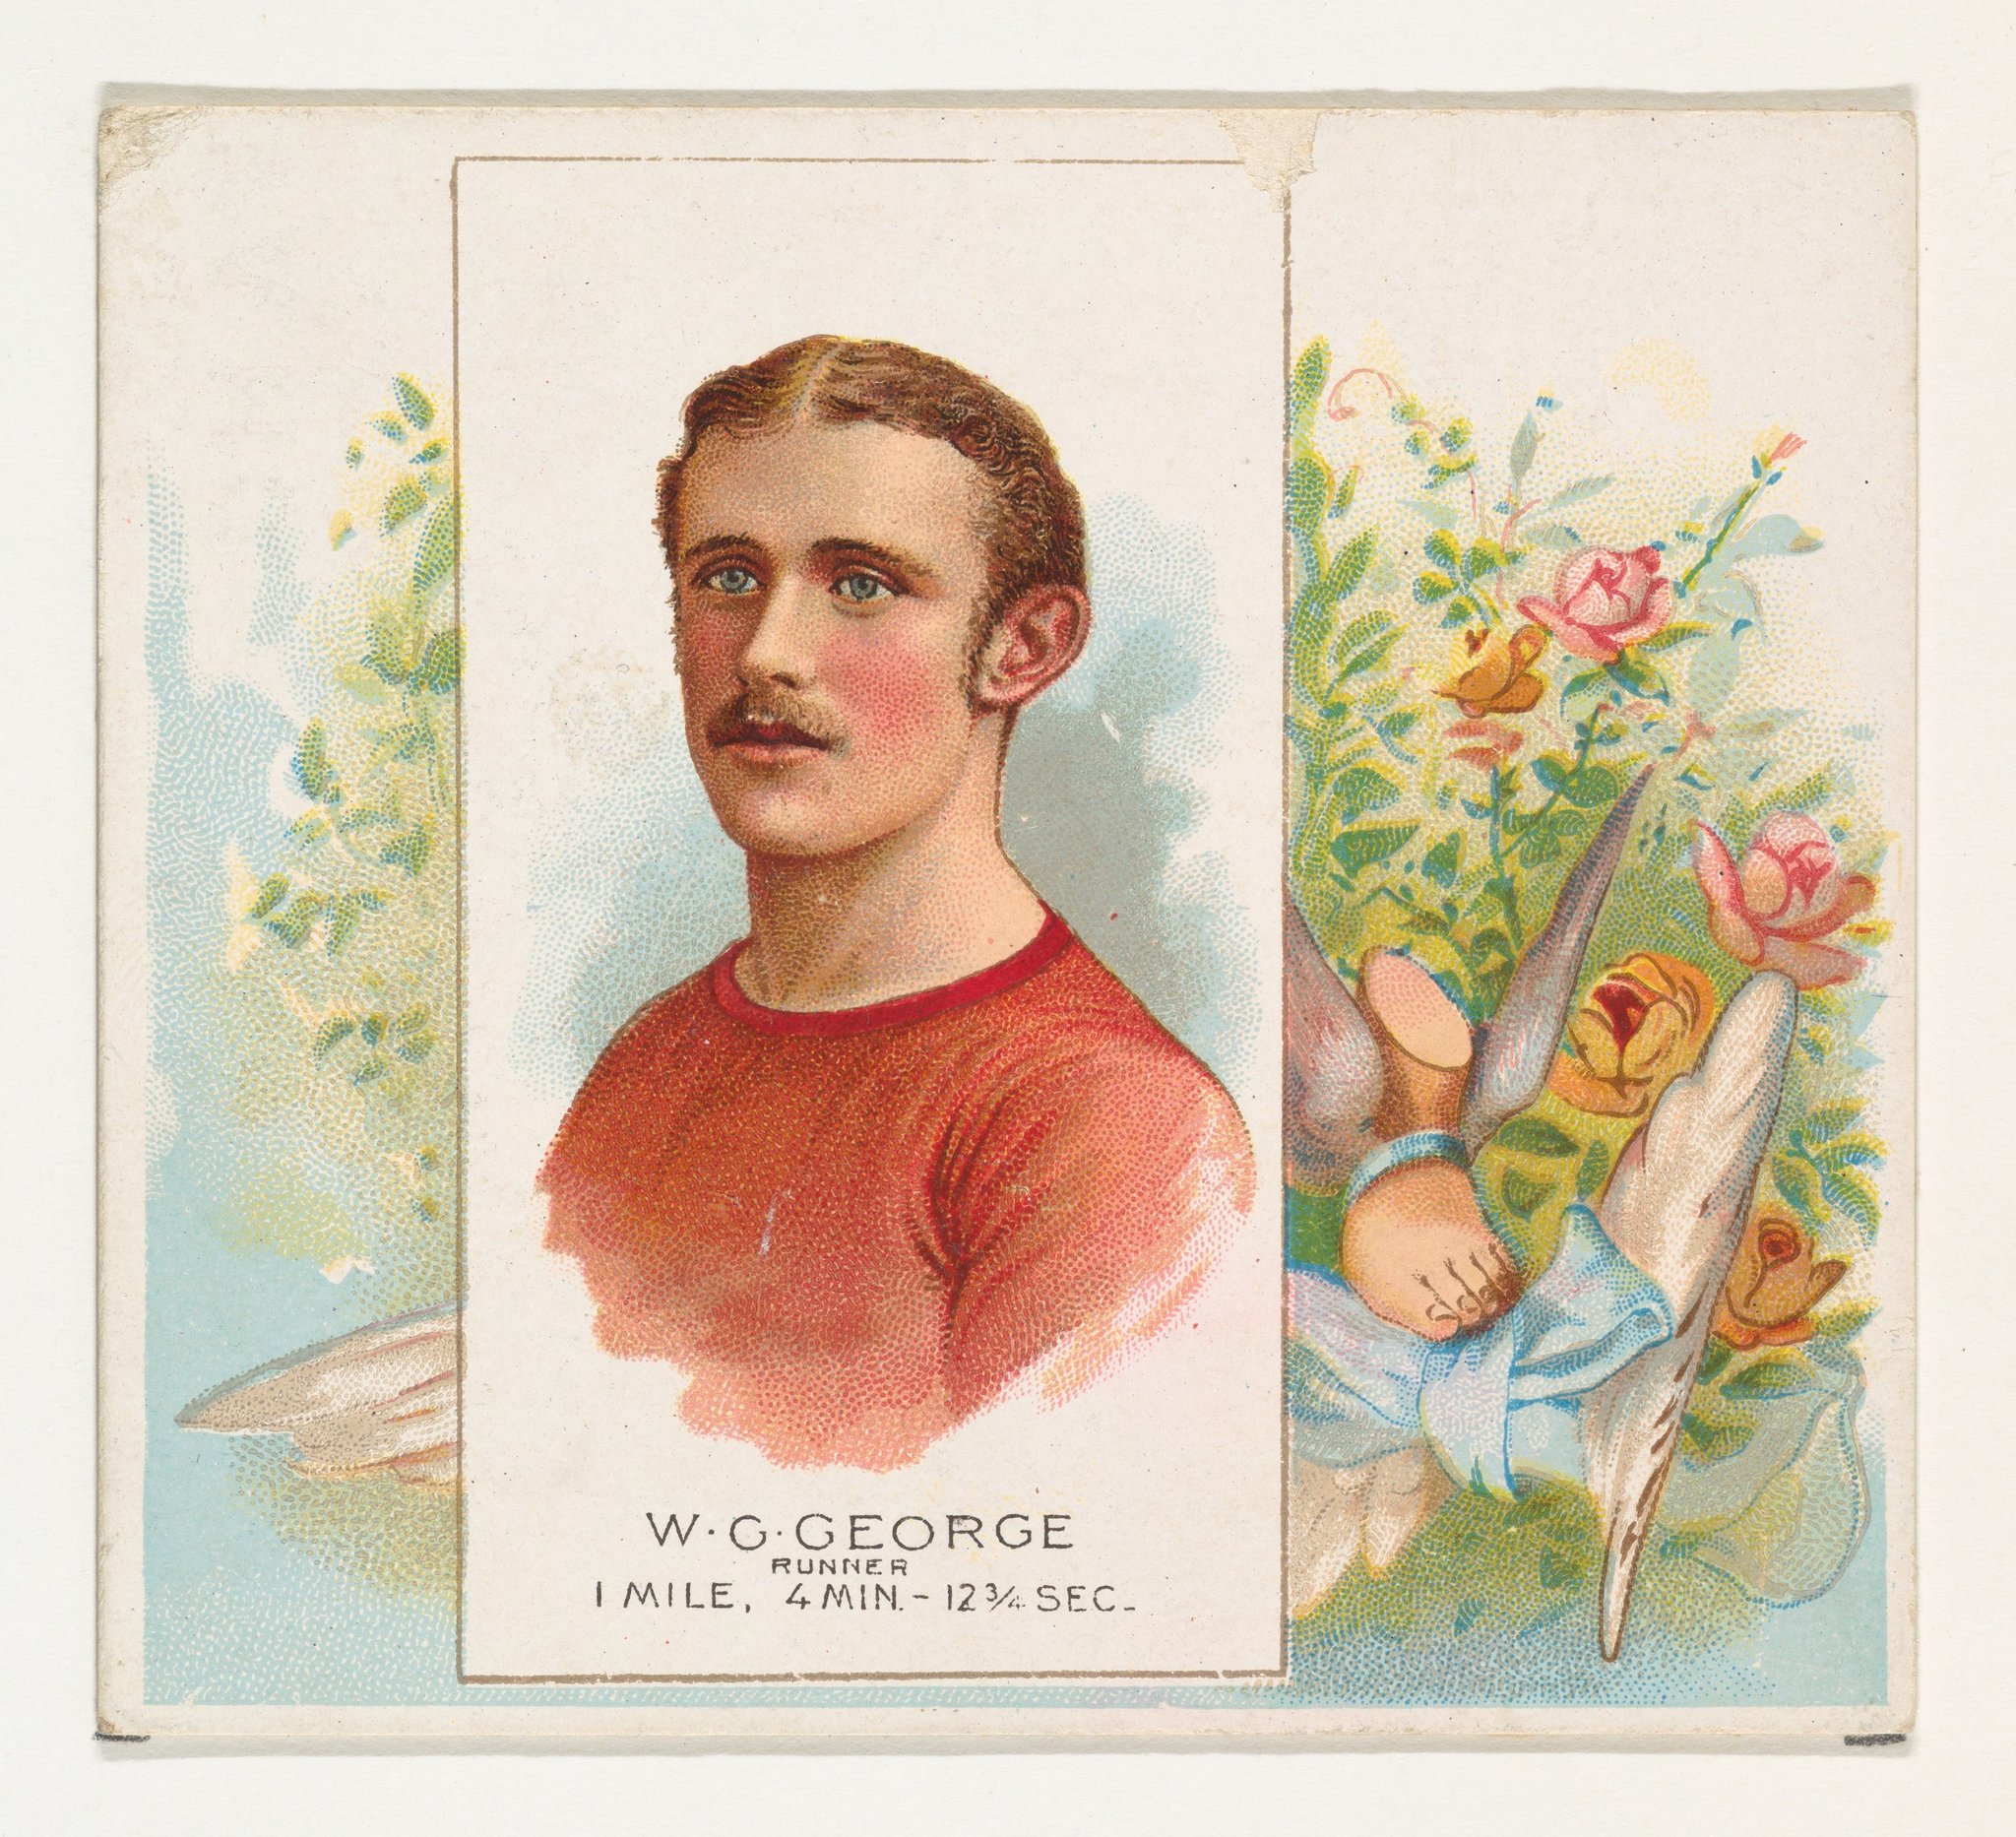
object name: print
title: W.G. George, Runner, from World's Champions, Second Series (N43) for Allen & Ginter Cigarettes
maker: allen & ginter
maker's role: publisher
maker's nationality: american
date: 1888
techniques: lithography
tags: men,portraits,athletes